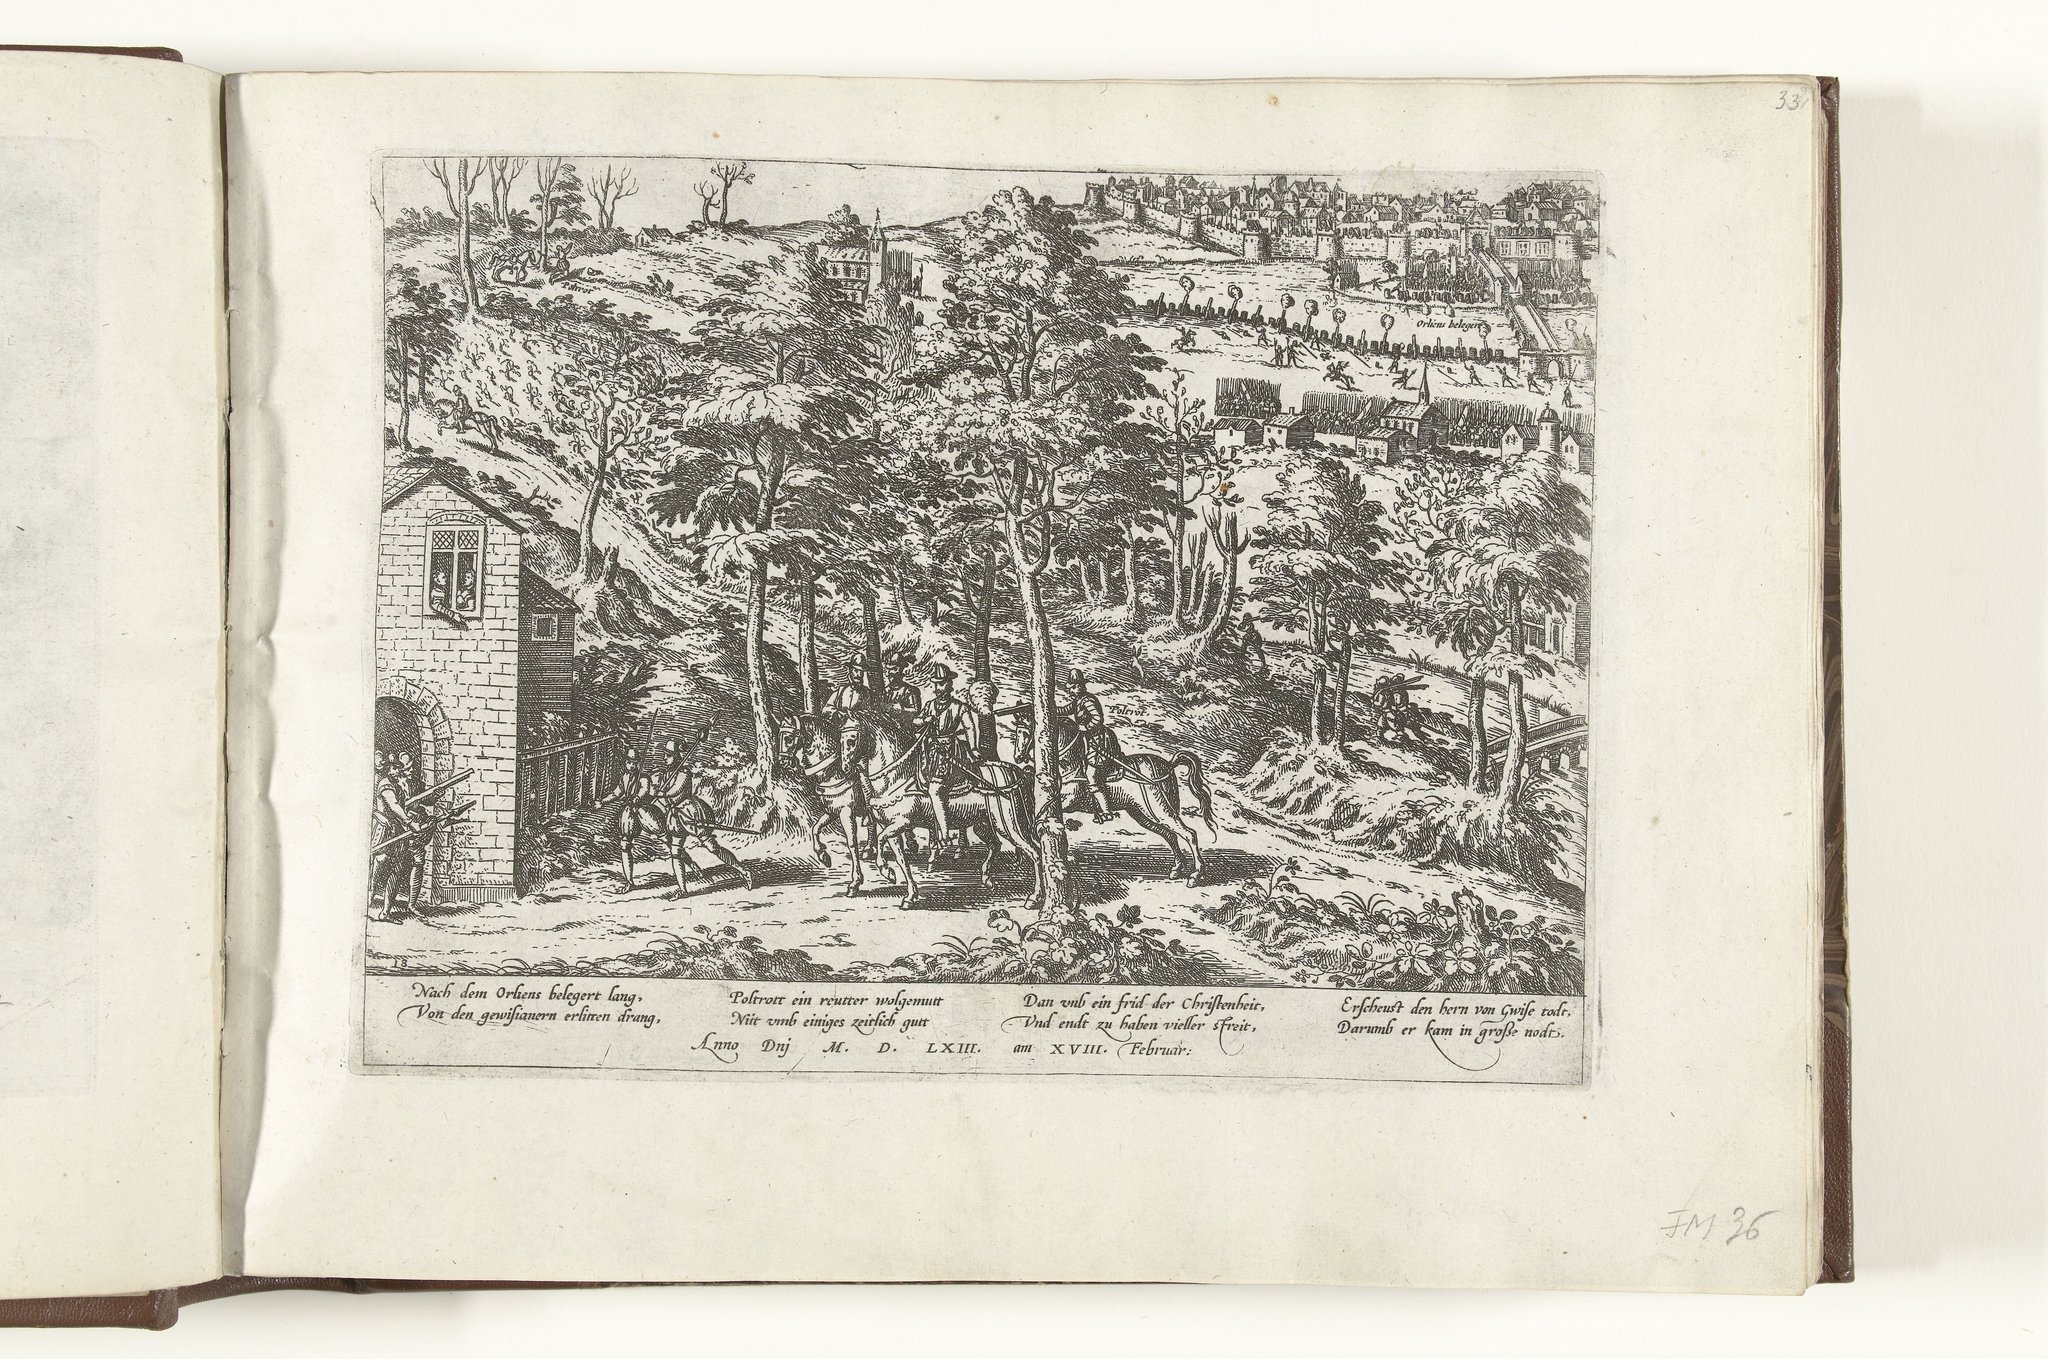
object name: history print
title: Serie 3: Franse Godsdienstoorlogen, 1559-1573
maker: frans hogenberg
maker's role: print maker, publisher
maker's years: 1538-1590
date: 1565-1573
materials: paper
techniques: etching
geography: cologne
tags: paris, siege, position war, violent death, being killed; being mishandled and maltreated; seeking death, attempt, political murder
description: Gekopieerd naar de prent in: Jean Tortorel et Jacques Perrissin, Premier volume contenant quarante tableaux ou Histoires diverses qui sont memorables touchant les Guerres, Massacres et Troubles advenus en France en ces dernieres annees : le tout recueilly selon le tesmoignange de ceux qui y ont esté en personne et qui les ont veus : lesquels sont pourtraits à la vérité, Genève ca. 1570. Bibliotheek Rijksmuseum: 329 A 2, pl. 24 [ontbreekt in dit exemplaar].